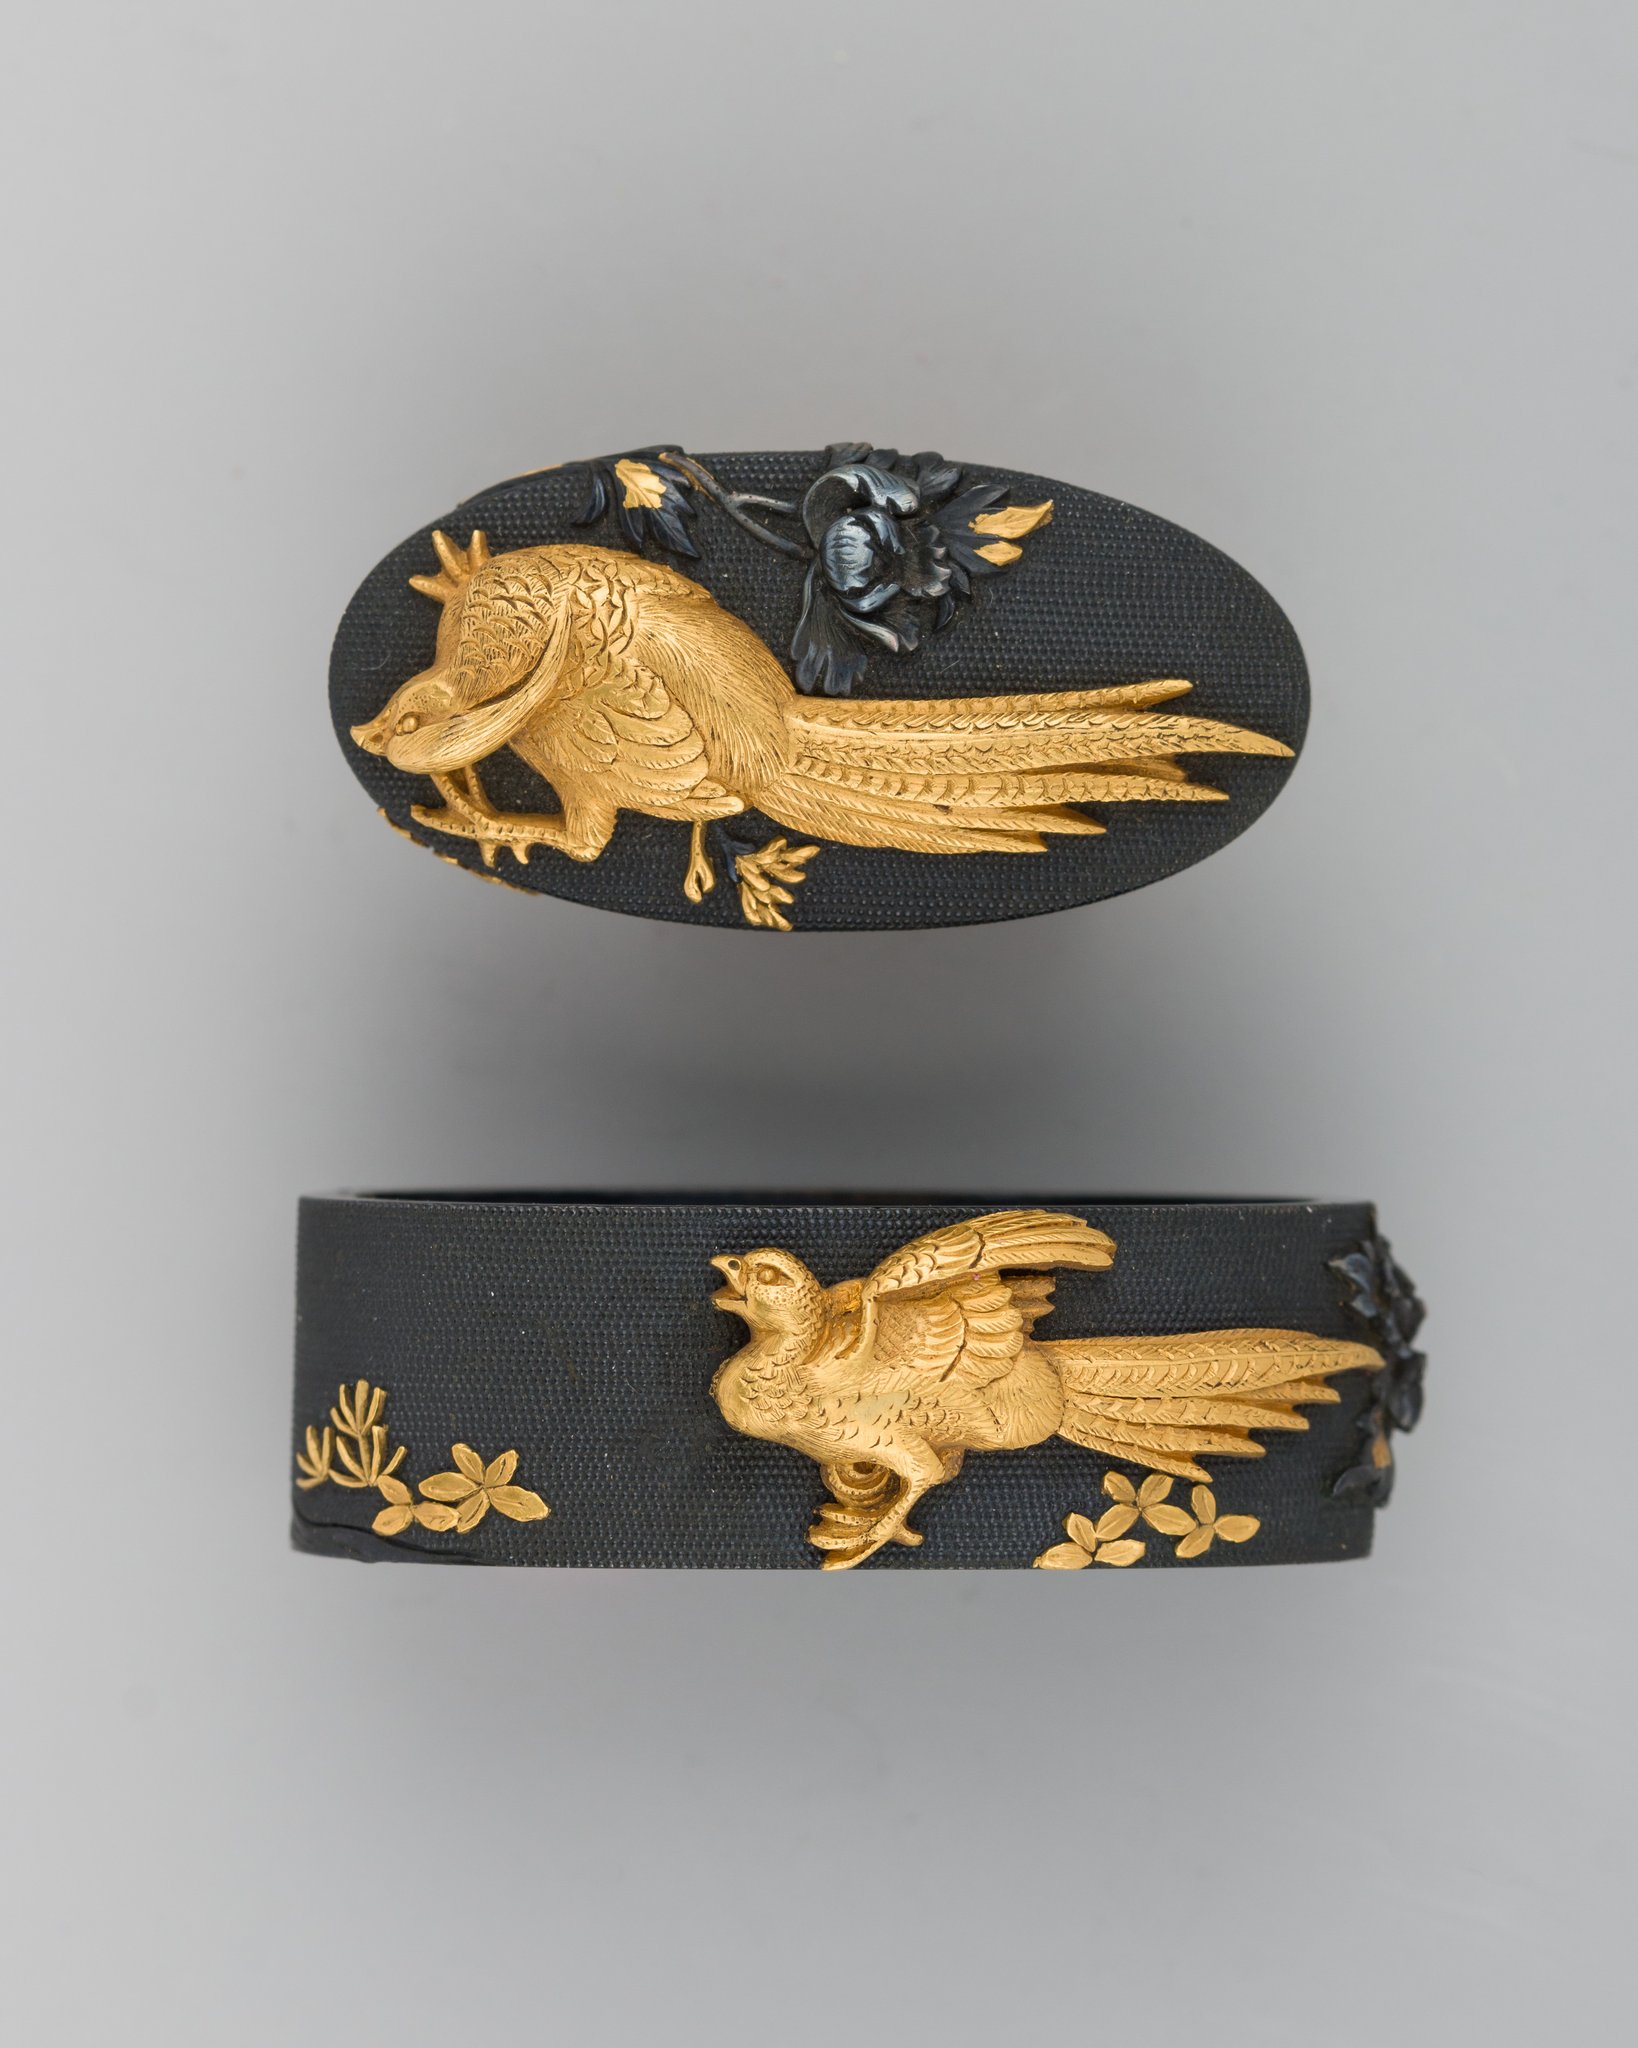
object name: sword pommel kashira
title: Sword Pommel (Kashira)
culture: japanese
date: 1801-1900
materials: gold alloy, gold, silver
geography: japan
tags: birds